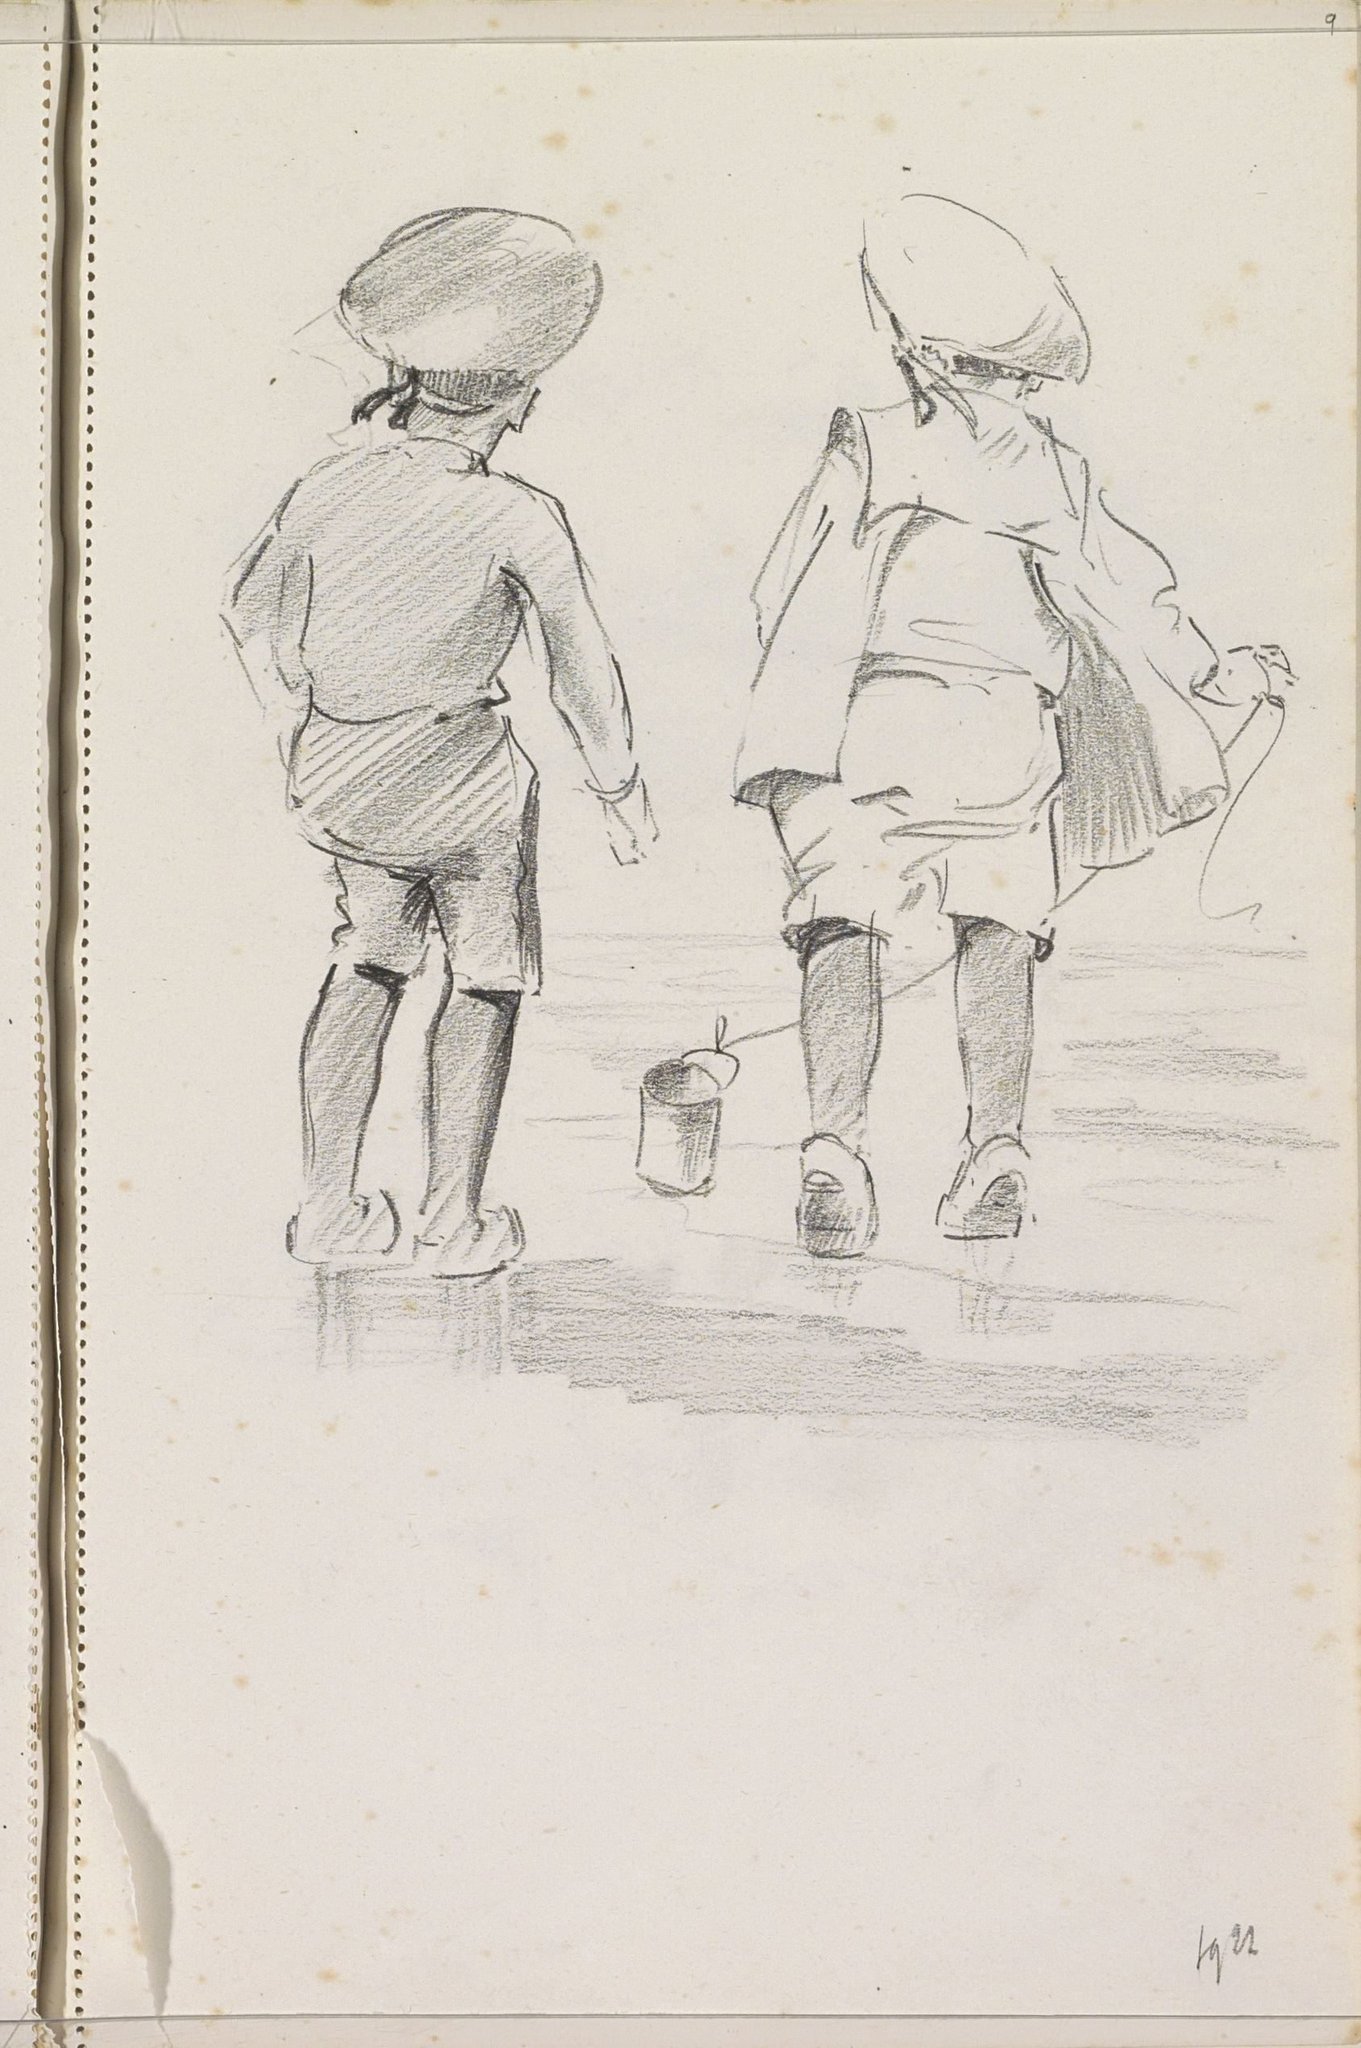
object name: sketchbook leaf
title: Twee spelende kinderen aan zee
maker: otto verhagen (i)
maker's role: draughtsman, print maker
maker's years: 1885-1951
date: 1922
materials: chalk, paper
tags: children's games and plays, child, beach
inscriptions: date: ‘1922’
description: De kinderen spelen met een emmer aan een touw. Pagina 9 uit een schetsboek met 34 bladen.